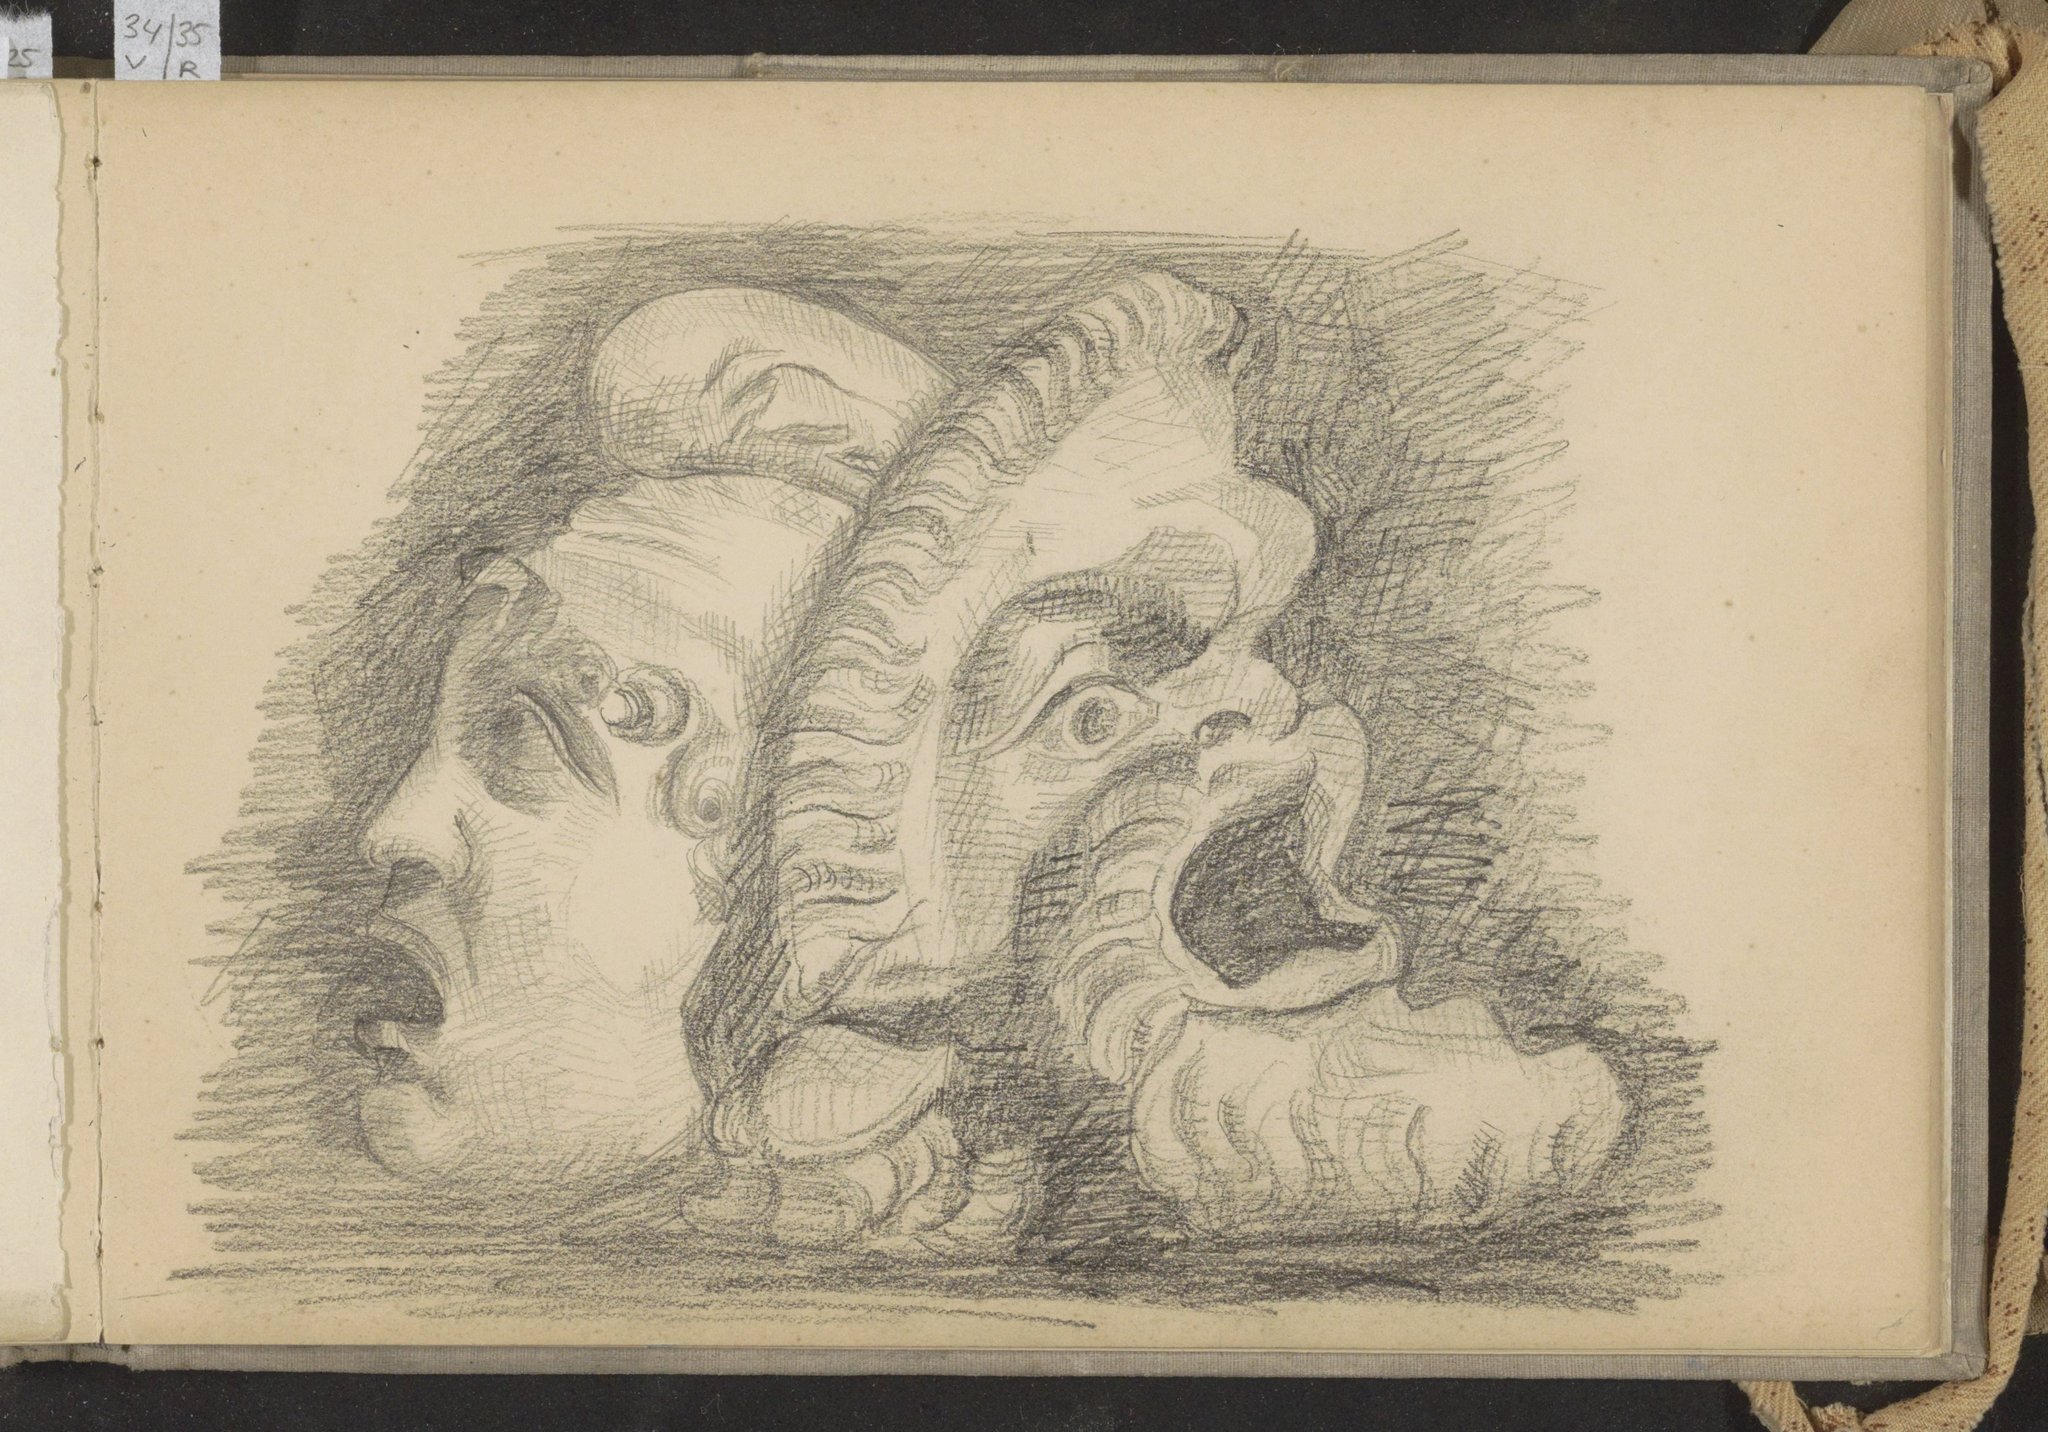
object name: sketchbook leaf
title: Twee beeldhouwwerken van koppen met opengesperde monden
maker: johanna van de kamer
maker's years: 1873-1922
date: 1890-1922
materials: paper, pencil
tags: mouth wide open, piece of sculpture, reproduction of a piece of sculpture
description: Blad 34 recto uit een schetsboek met 43 bladen.